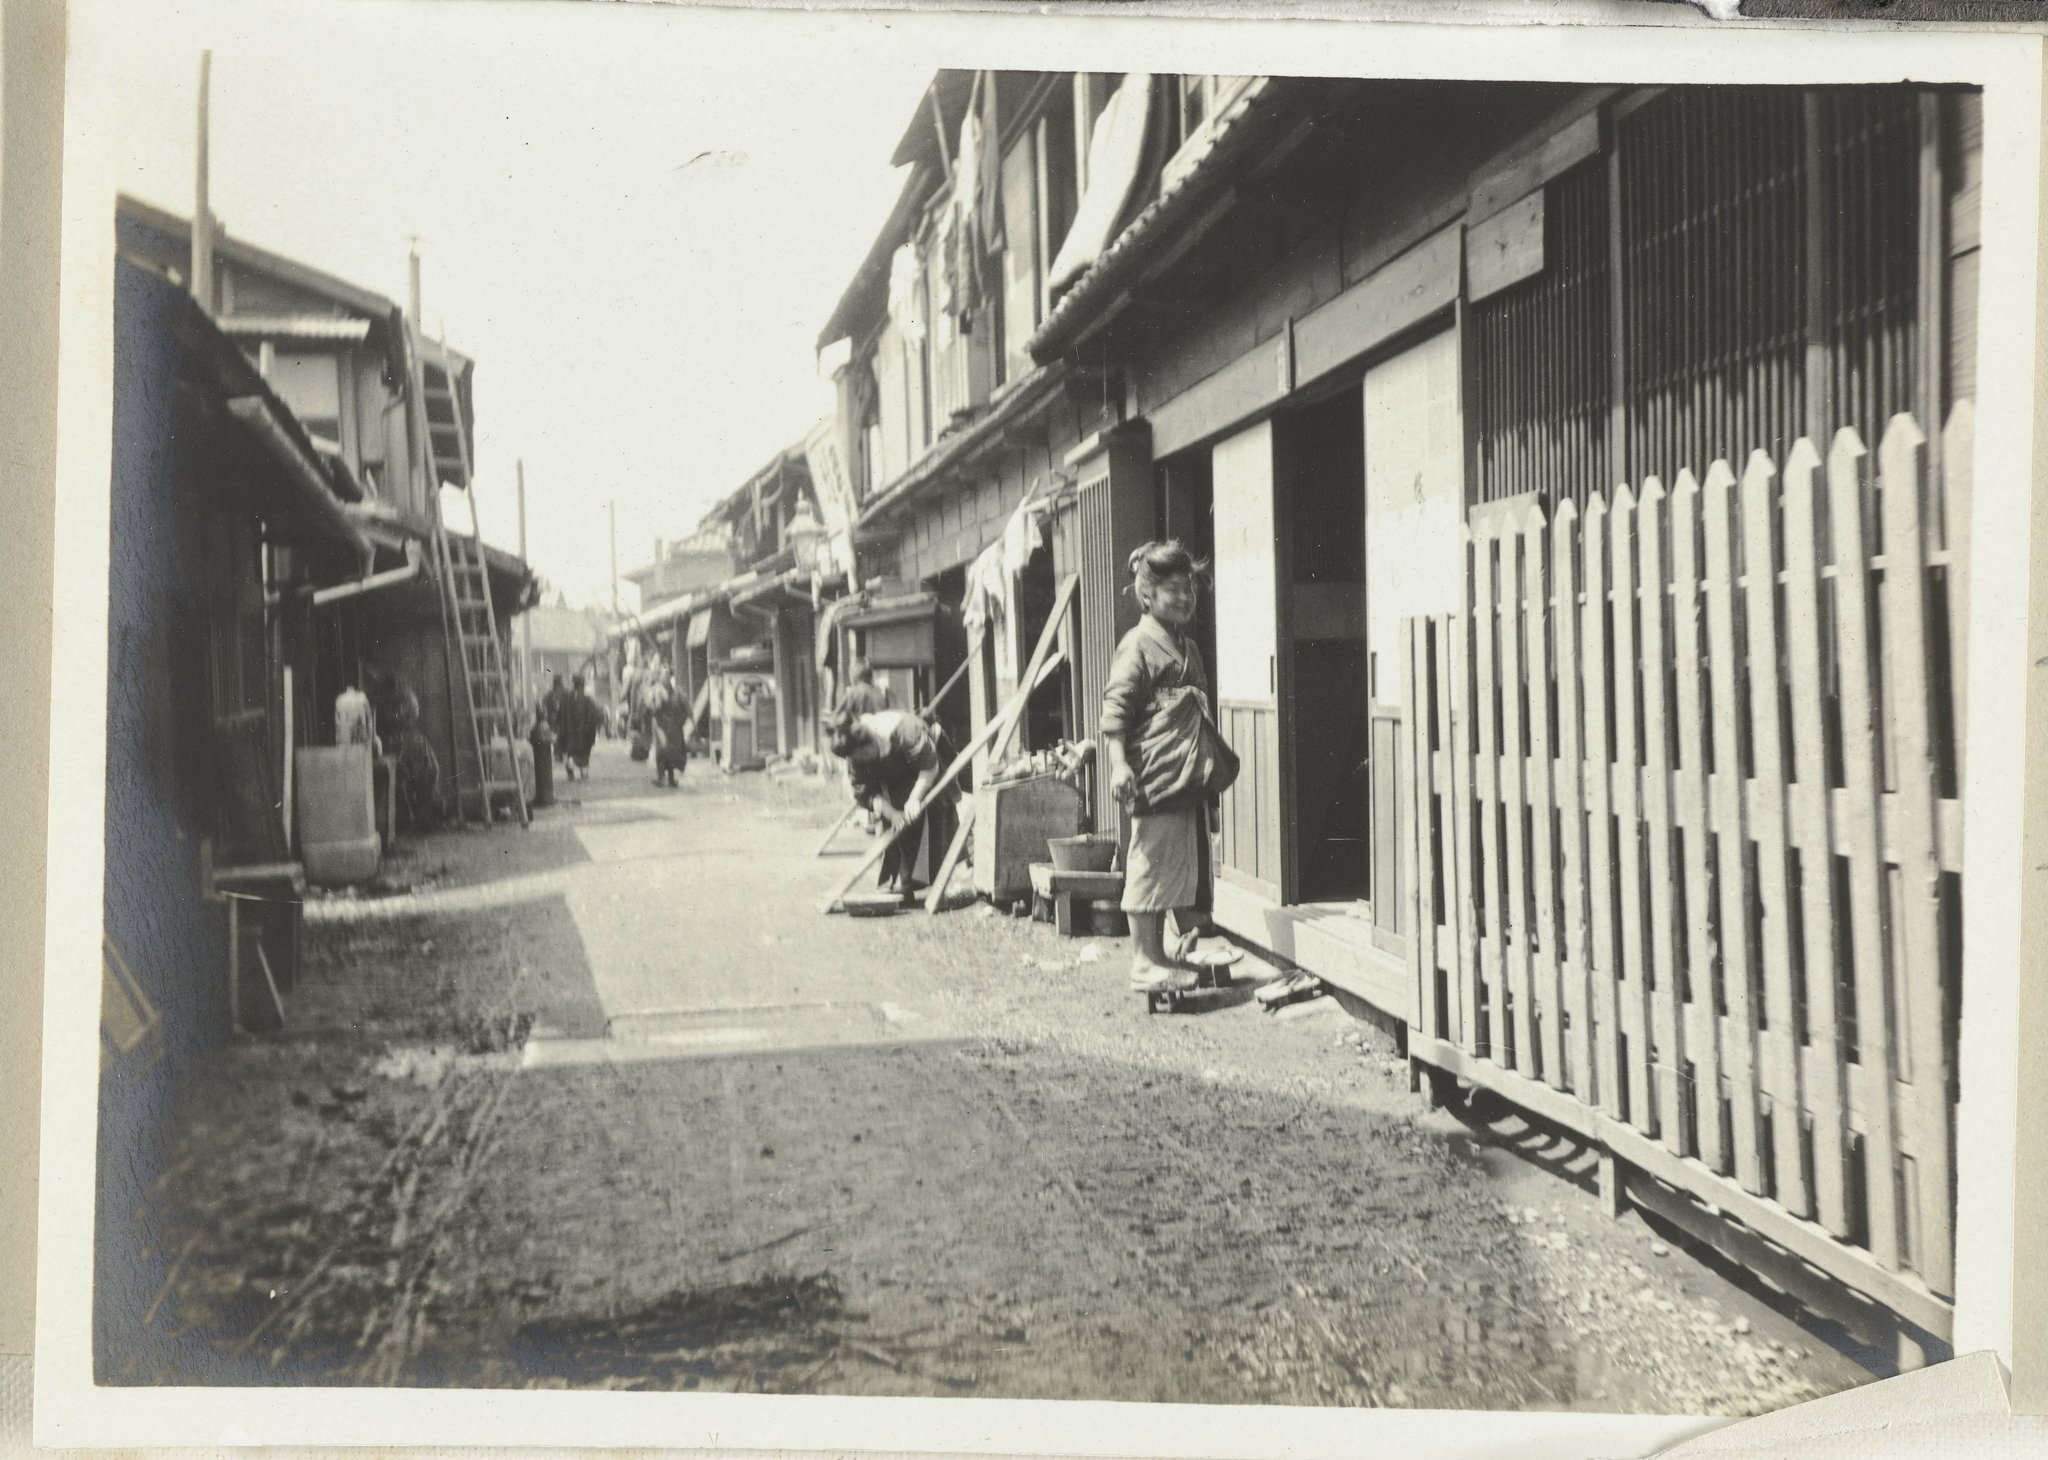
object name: photograph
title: Yokohama side street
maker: geldolph adriaan kessler (dolph)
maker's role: fotograaf, industrieel, voetballer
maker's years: 1884-1945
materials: cardboard, photographic support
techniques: gelatin silver print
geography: yokohama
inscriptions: title: ‘Yokohama side street’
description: Straatgezicht in Yokohama. Onderdeel van het fotoalbum van Dolph Kessler met opnamen die hij maakte tijdens zijn verblijf in Engeland en op een wereldreis die hij als secretaris van Henri Deterding (directeur Koninklijke Olie) ondernam naar Nederlands-Indië, Japan, China en de Verenigde Staten, tussen 1906 en 1908.